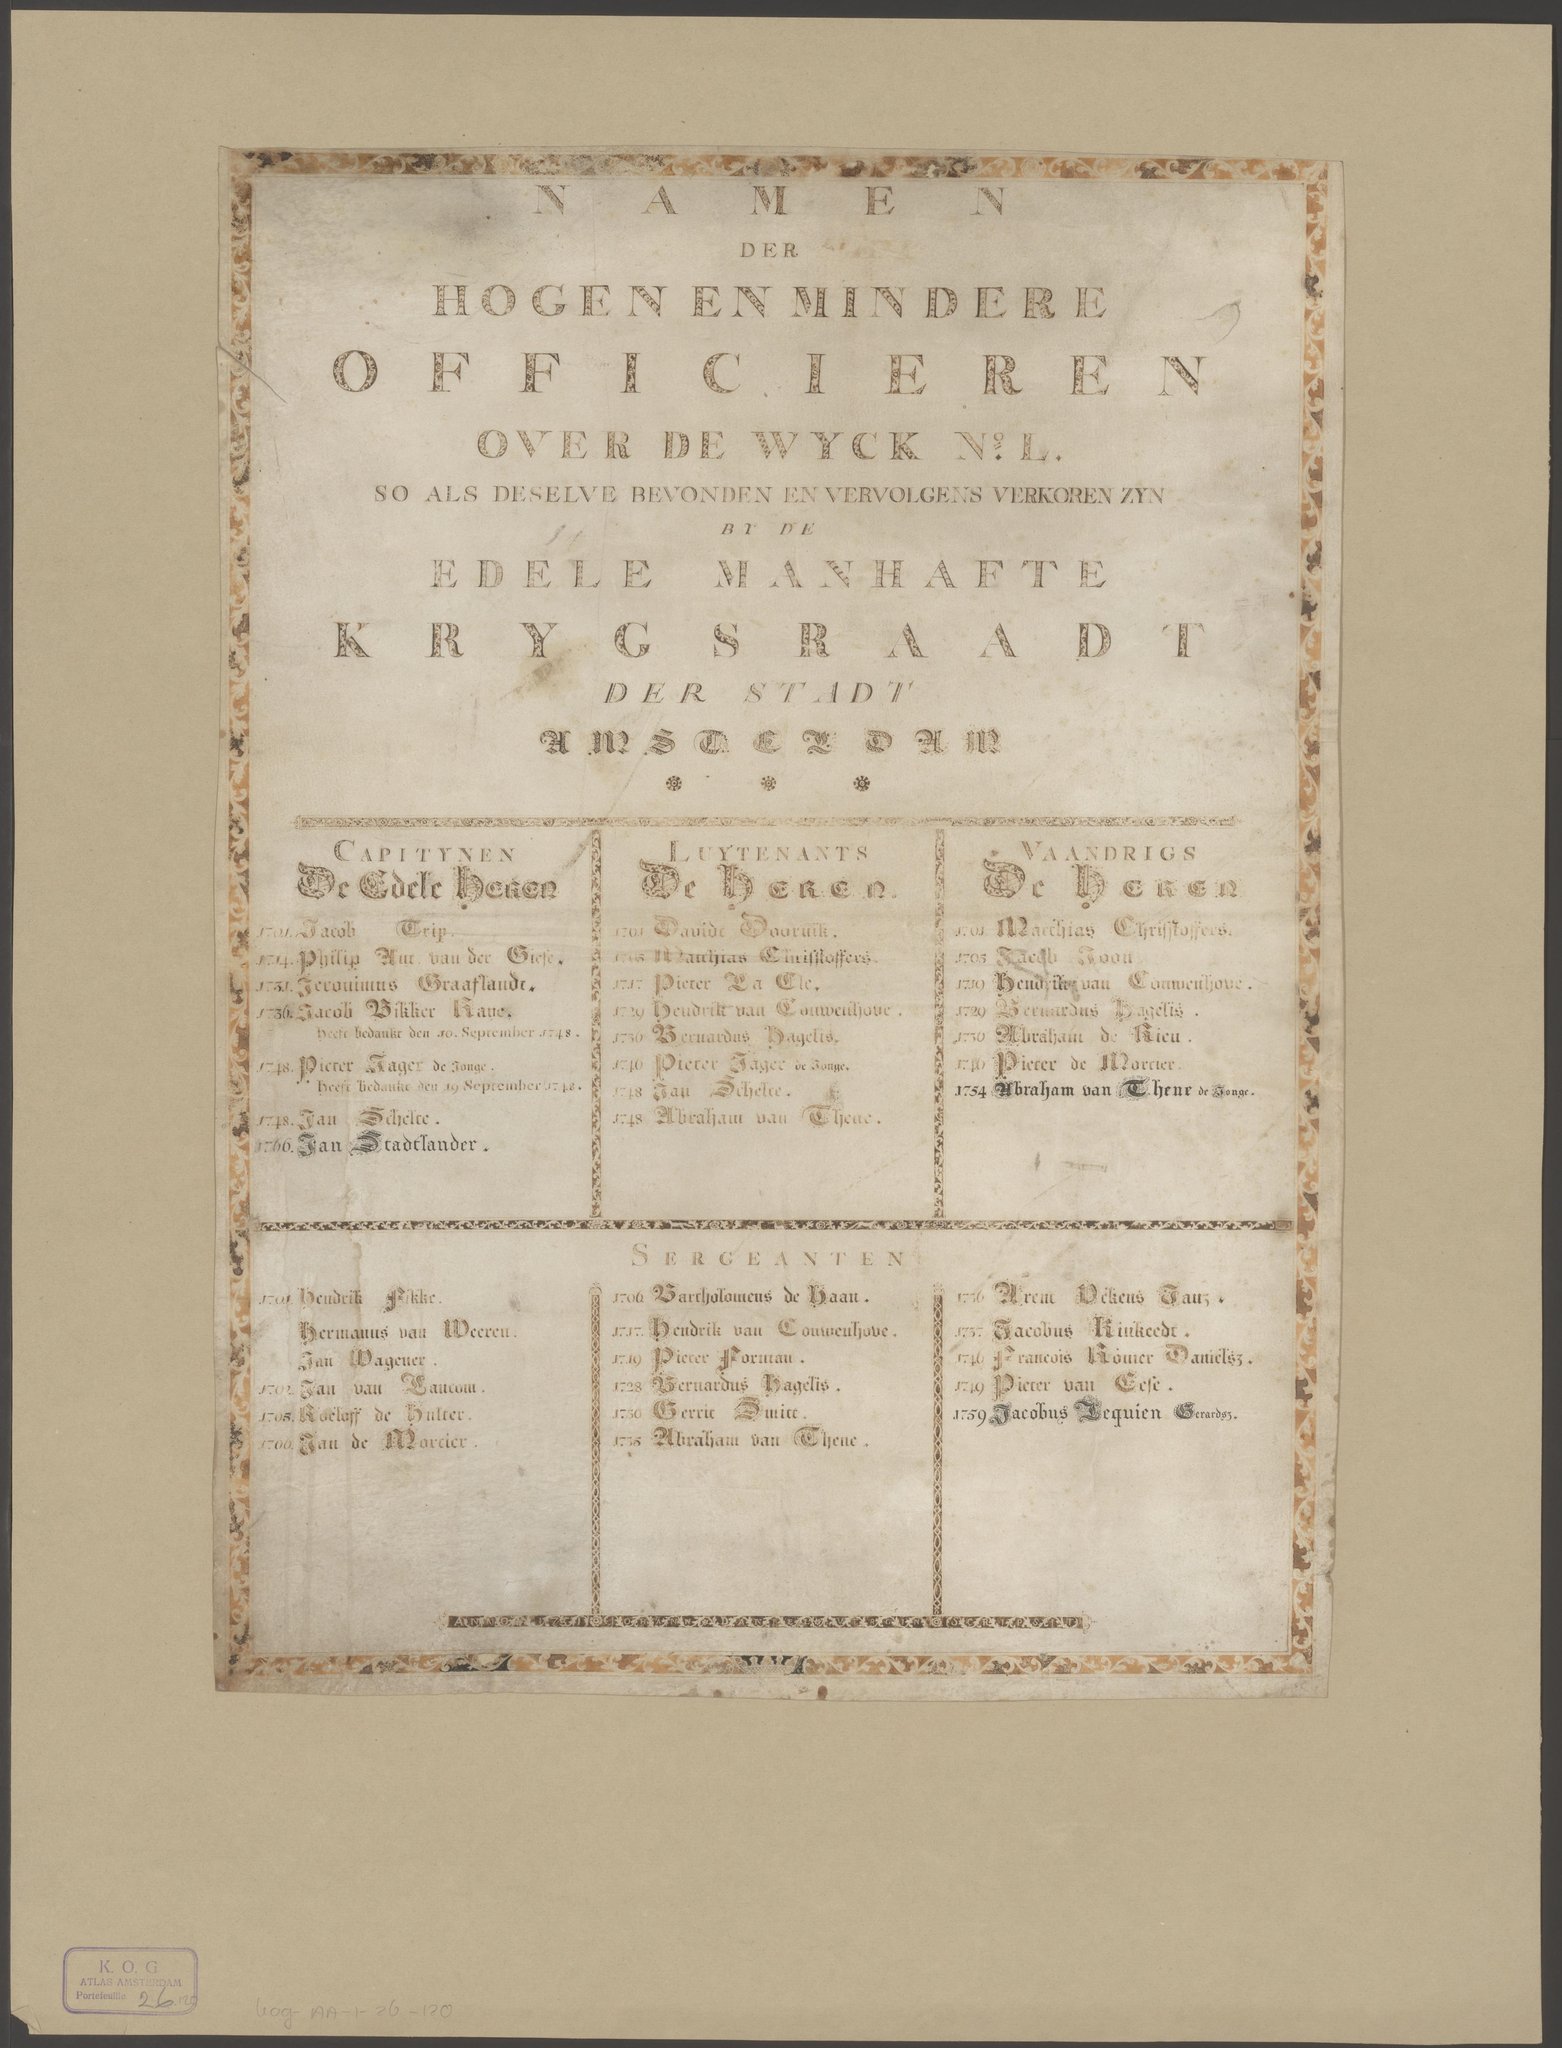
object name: naamlijst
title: Tabel met namen van officieren van burgerwijk L te Amsterdam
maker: johann daniel vergin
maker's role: schrijver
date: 1751-1766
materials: ink, parchment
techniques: pen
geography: northern netherlands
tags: military service (+ citizen soldiery, civil guard, citizen militia), amsterdam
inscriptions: collector's mark: Lugt 1641b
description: Onderwerpsrubriek binnen de Atlas Amsterdam: Herinneringen aan de Schutterij.